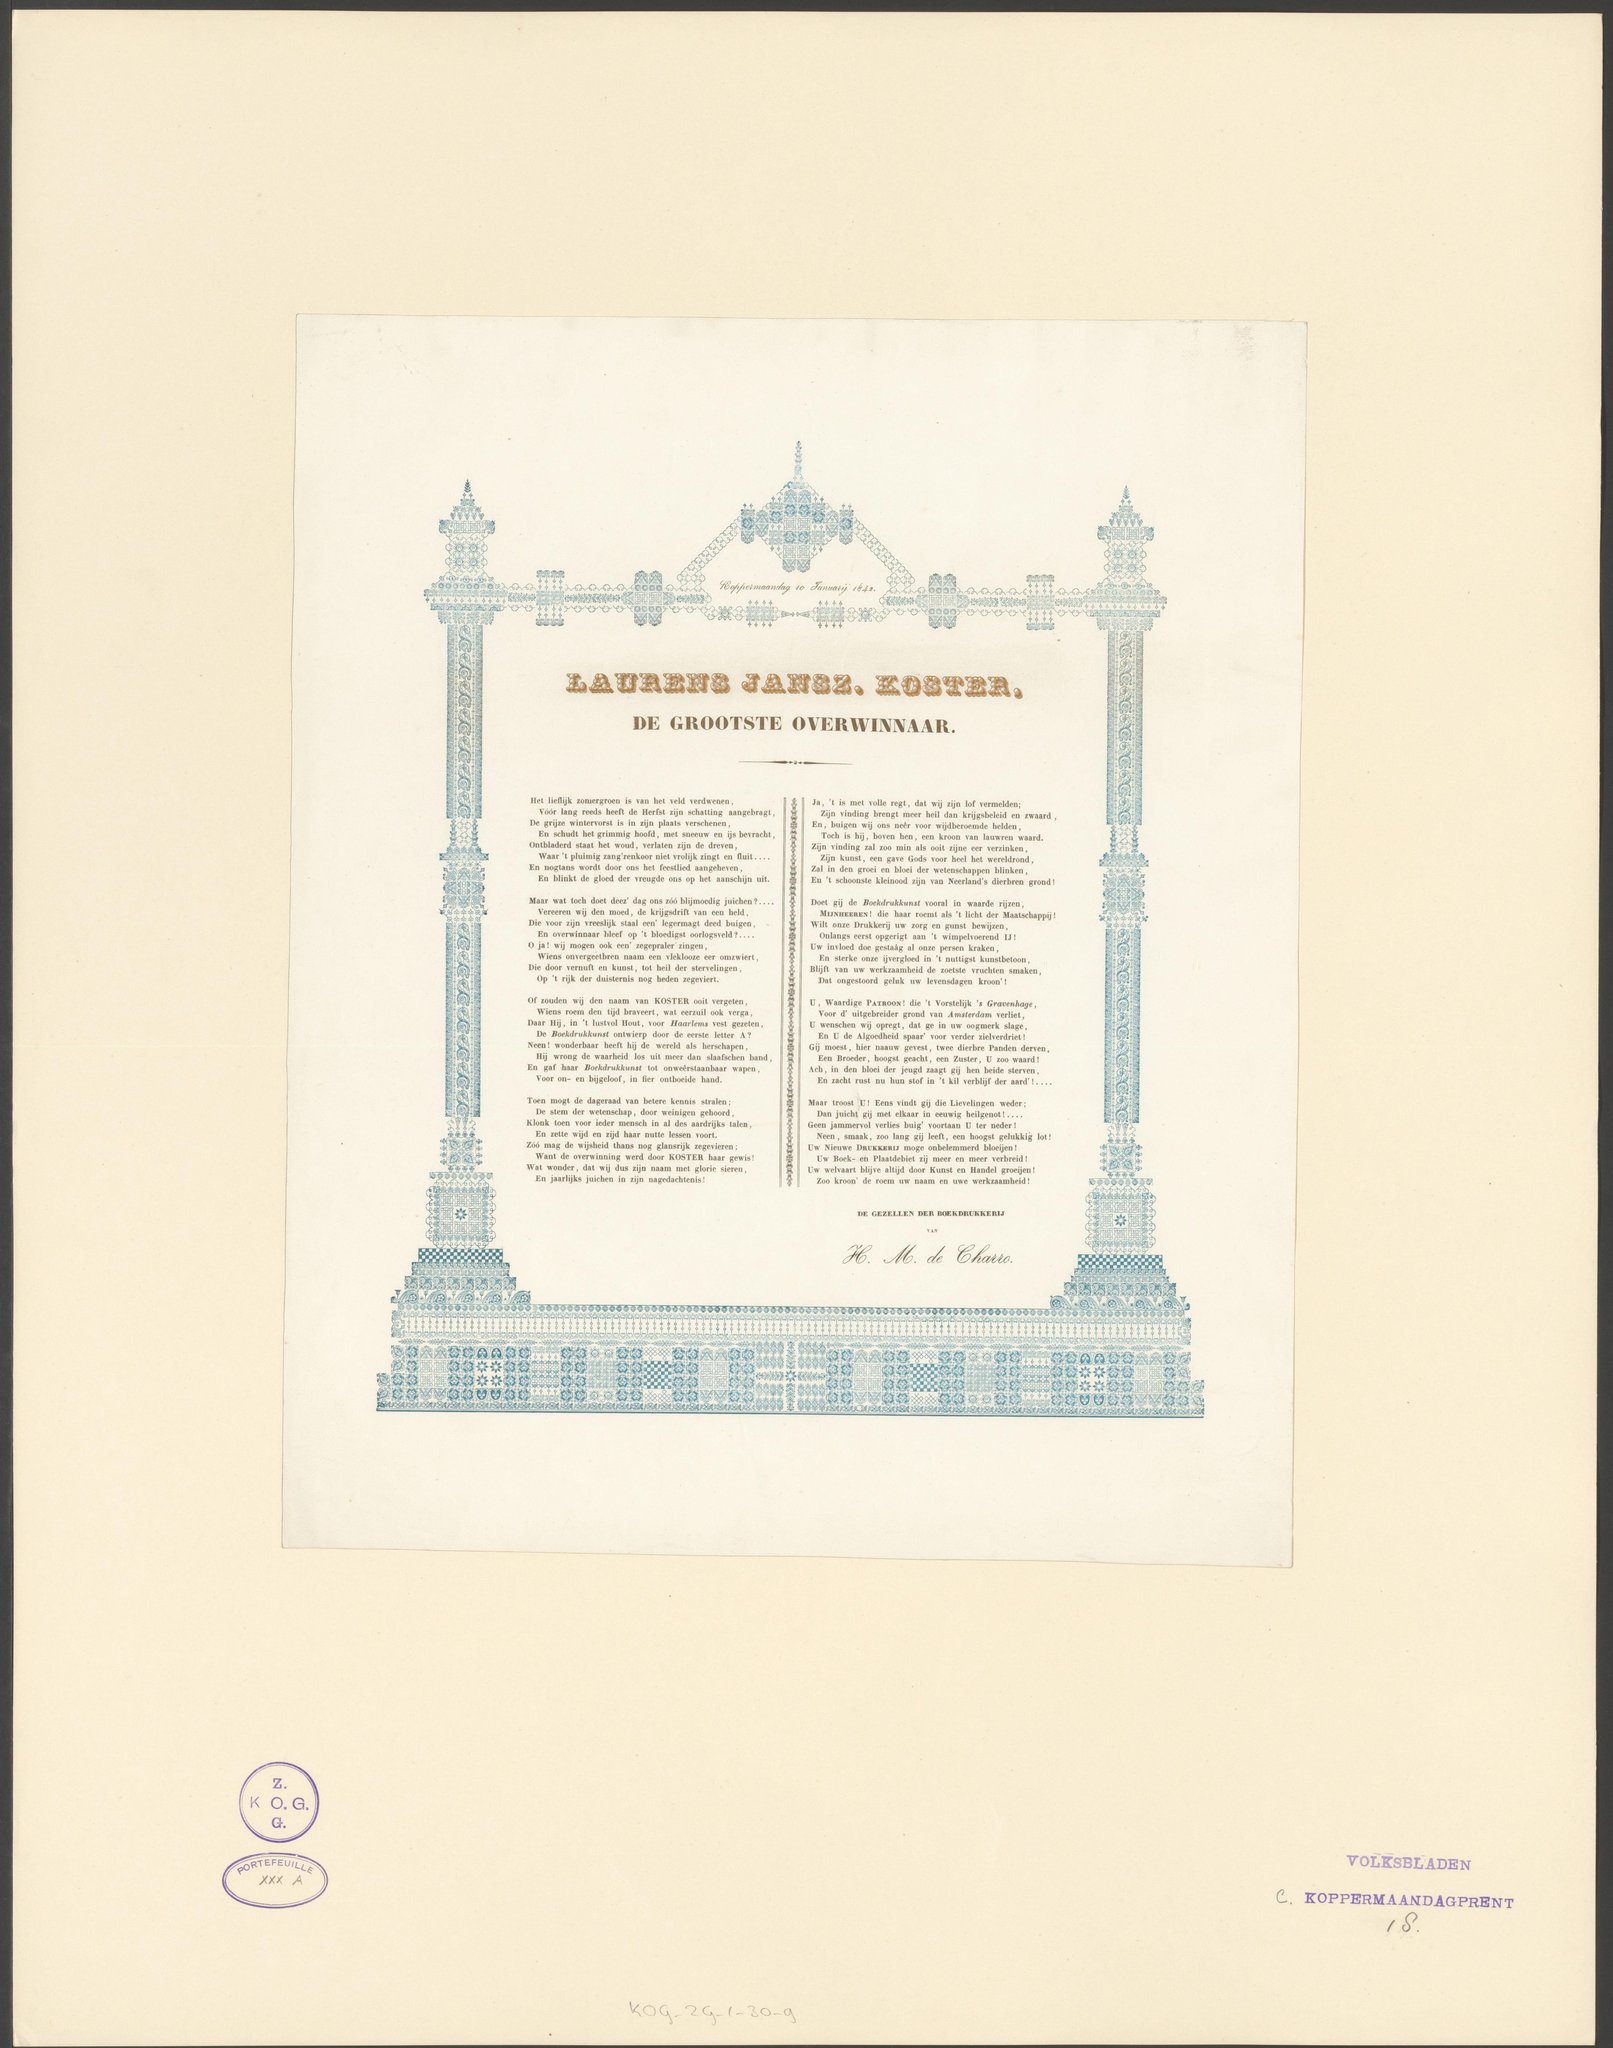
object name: koppermaandagprent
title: Koppermaandagprent met een lofzang op Laurens Janszoon Coster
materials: paper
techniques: letterpress printing, printing block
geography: amsterdam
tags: haarlem, 'blue monday'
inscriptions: stamp, stamp, collector's mark: Lugt 1641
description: Koppermaandagprent door de gezellen van de boekdrukkerij van H.M. de Charro te Amsterdam, ter gelegenheid van Koppermaandag 10 januari 1842. In het midden een vers in twee kolommen namens de gezellen. Onderwerpsrubrieken binnen de Atlas Zeden en Gewoonten: Zeden en Gewoonten in engeren zin. Volksleven. Volksbladen. Koppermaandagwenschen.